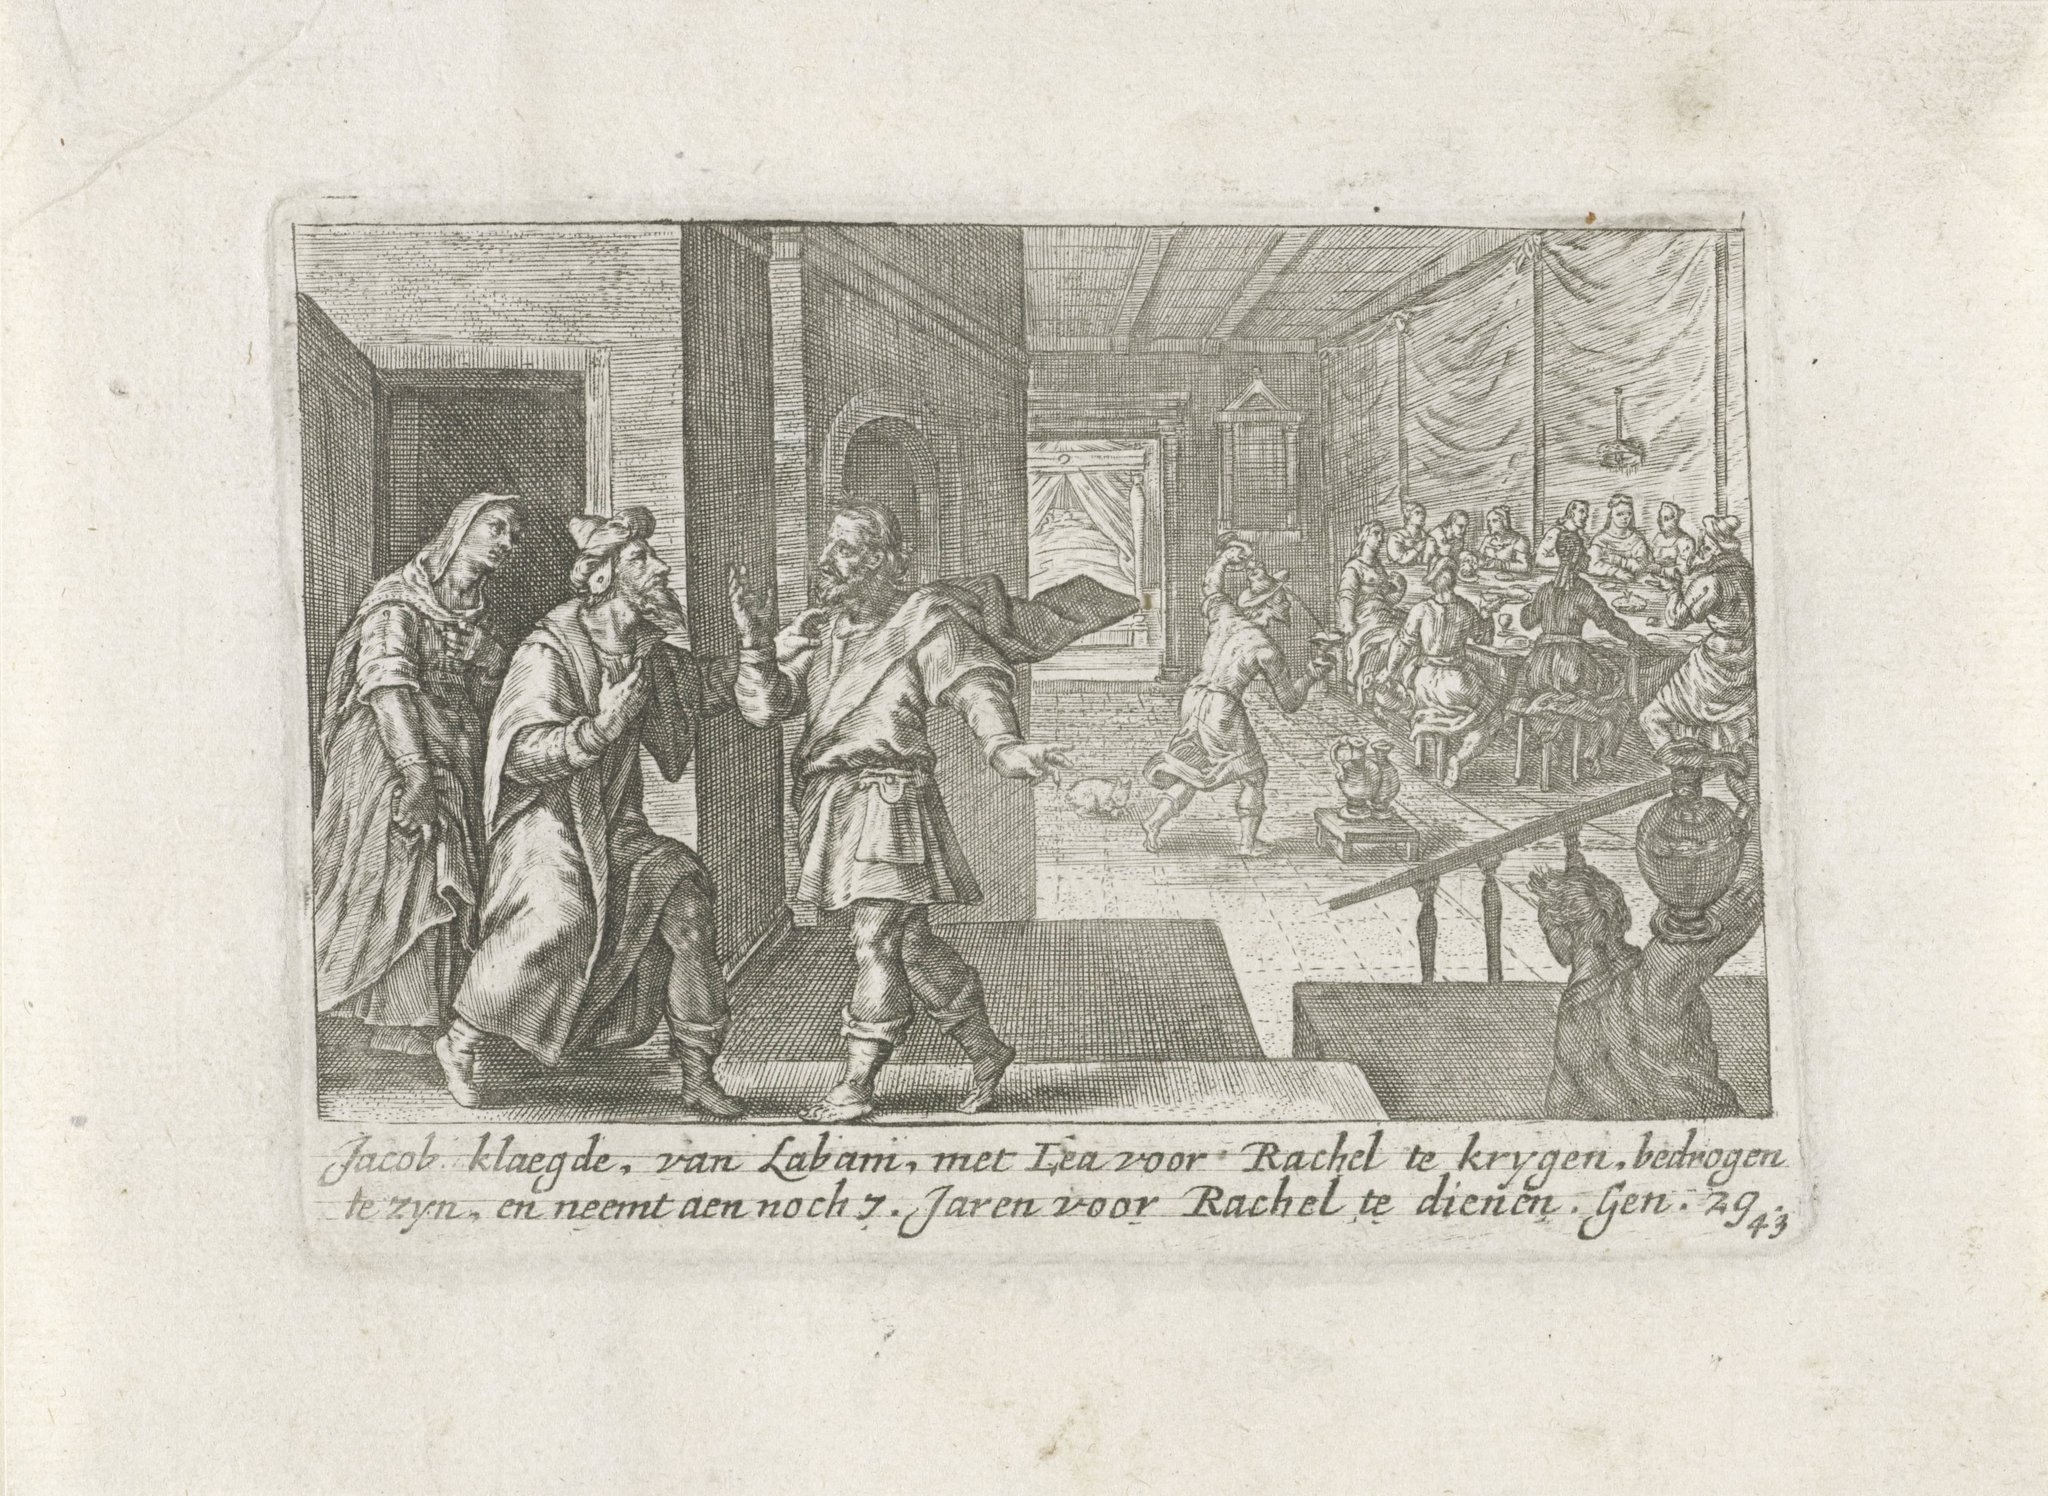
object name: print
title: Liber Genesis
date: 1700-1750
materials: paper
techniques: engraving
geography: amsterdam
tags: jacob requesting rachel after the seven years, the wedding-feast; laban substitutes leah for rachel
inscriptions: collector's mark: Lugt 2233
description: Laban bedriegt Jakob door hem in plaats van met Rachel met Lea te laten trouwen. Hij eist nogmaals zeven jaar arbeid van Jakob voor hij met Rachel mag trouwen. Op de achtergrond het bruiloftsfeest van Jakob en Lea. In de marge een tweeregelig onderschrift in het Nederlands.